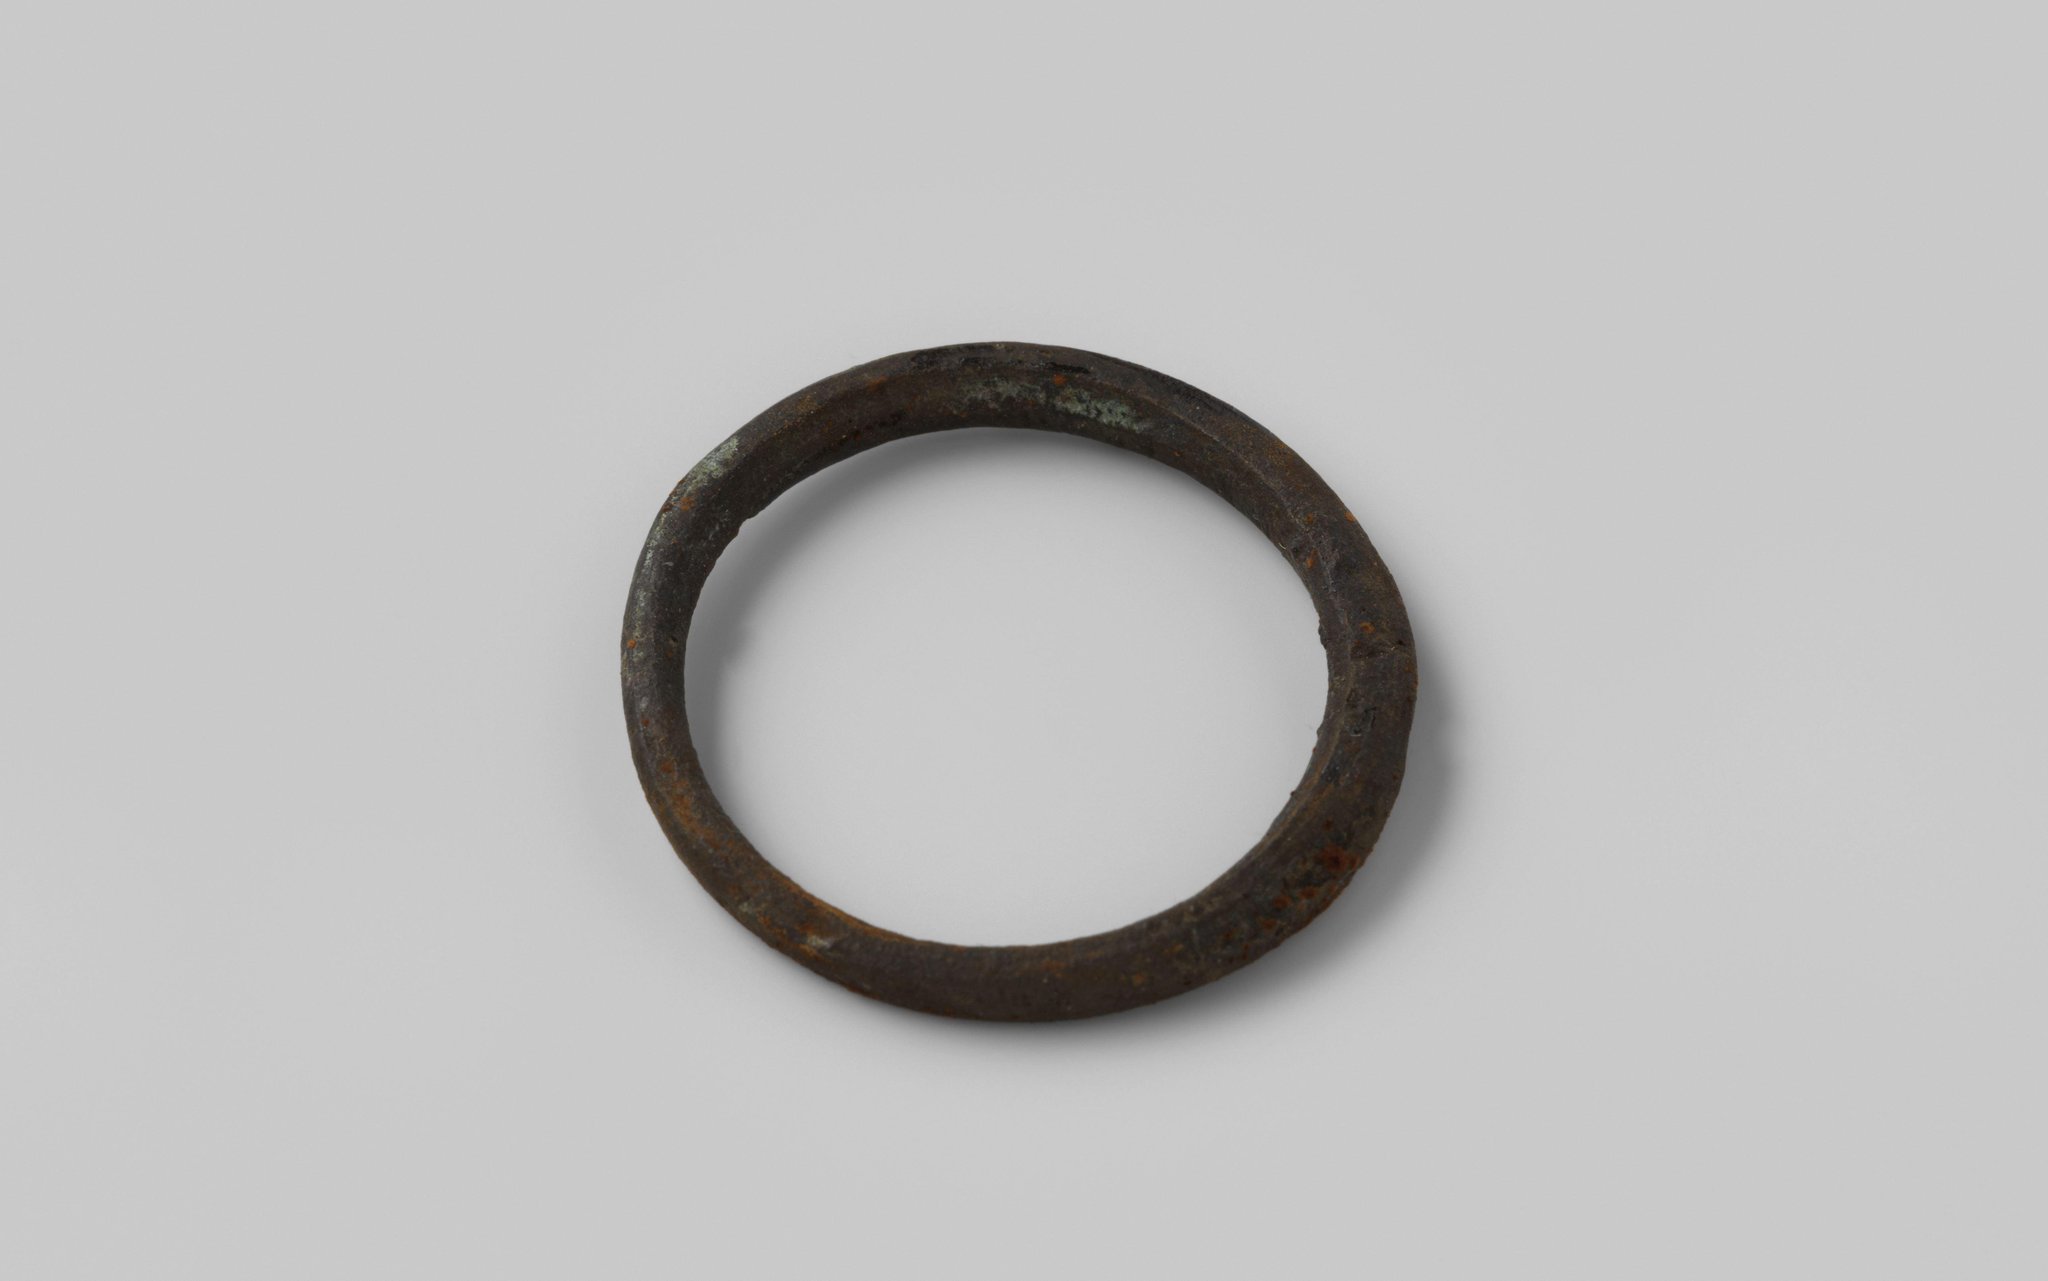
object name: ring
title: Ringvormig fragment uit het wrak van de Oost-Indiëvaarder Hollandia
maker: Anonymous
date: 1700-1743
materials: copper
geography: netherlands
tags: verenigde oostindische compagnie, hollandia (schip), annet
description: Varied parts or fragments, rings or ring-shaped fragments; id. 80H946.